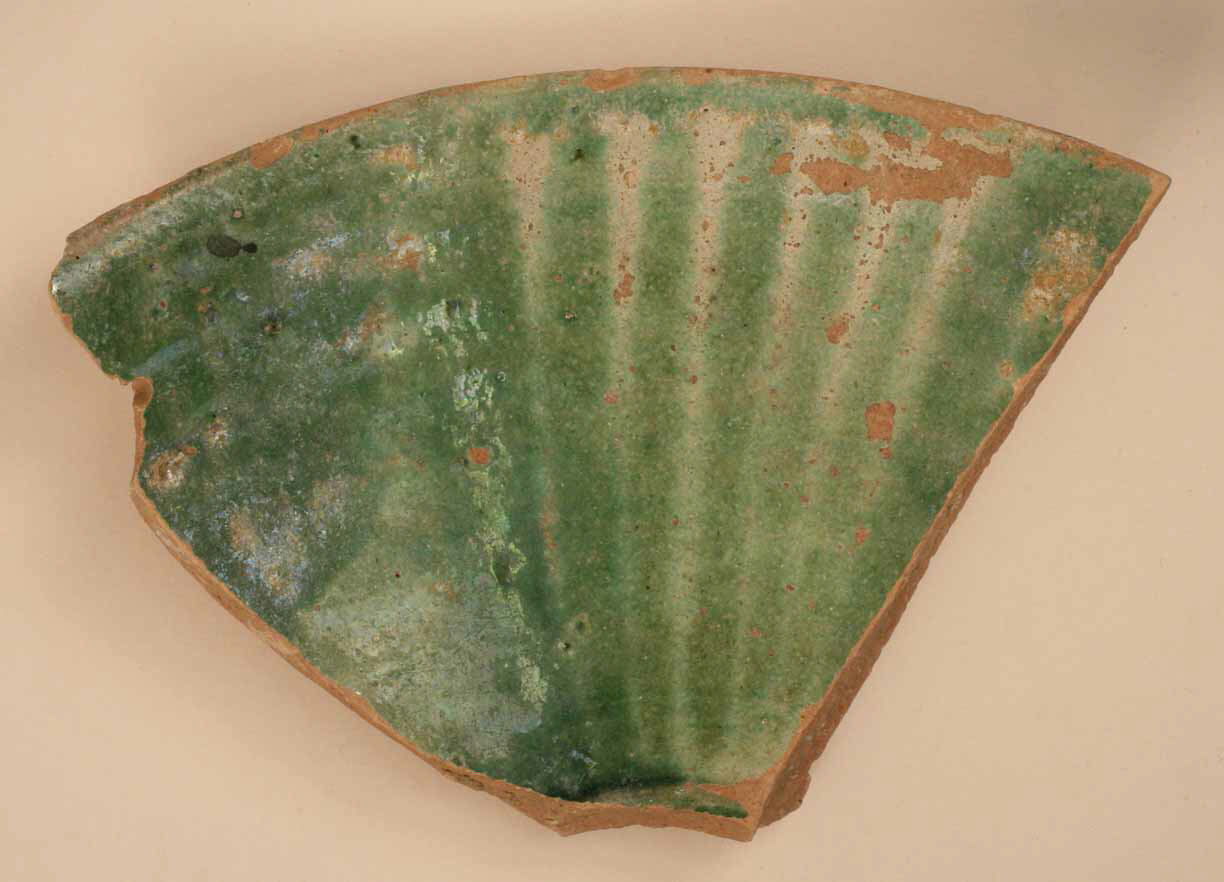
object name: fragment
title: Ceramic Fragment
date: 701-900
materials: earthenware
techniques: glazing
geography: iraq